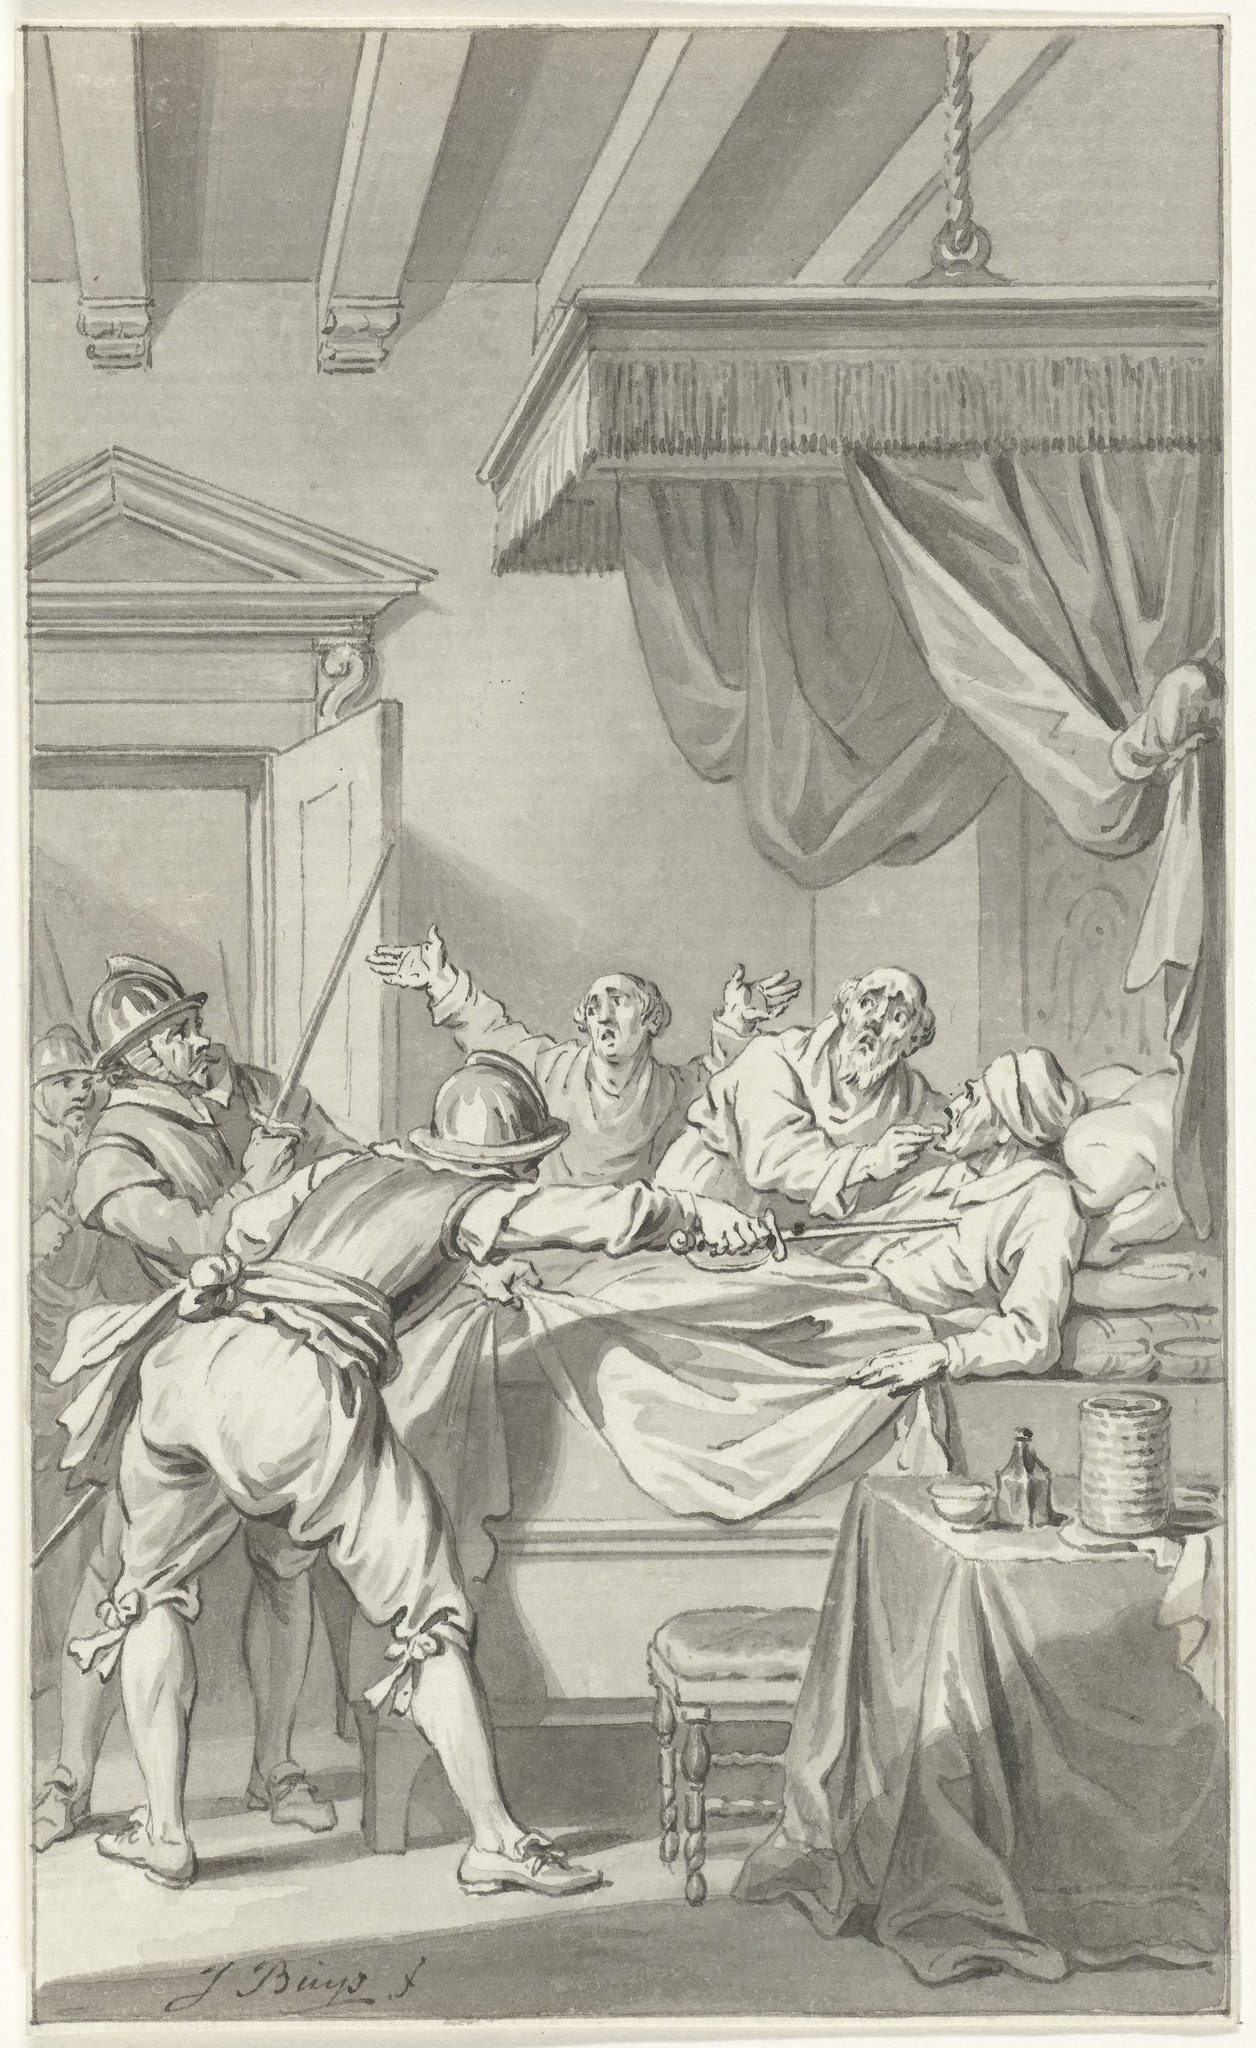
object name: design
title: De moord op burgemeester Beernt Proys in diens bed, te Utrecht, 1425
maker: jacobus buys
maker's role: draughtsman, print maker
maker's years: 1724-1801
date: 1789-1791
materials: ink, paper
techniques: brush, pen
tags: mayor, burgomaster, historical persons, murder, violent death, being killed; being mishandled and maltreated; seeking death, attempt, political murder, historical events and situations, utrecht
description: Ontwerptekening voor illustratie in: Jacobus Kok, Vaderlandsch Woordenboek, Johannes Allart, Amsterdam 1785-1799, 35 delen, dl. XXV, pl. III.